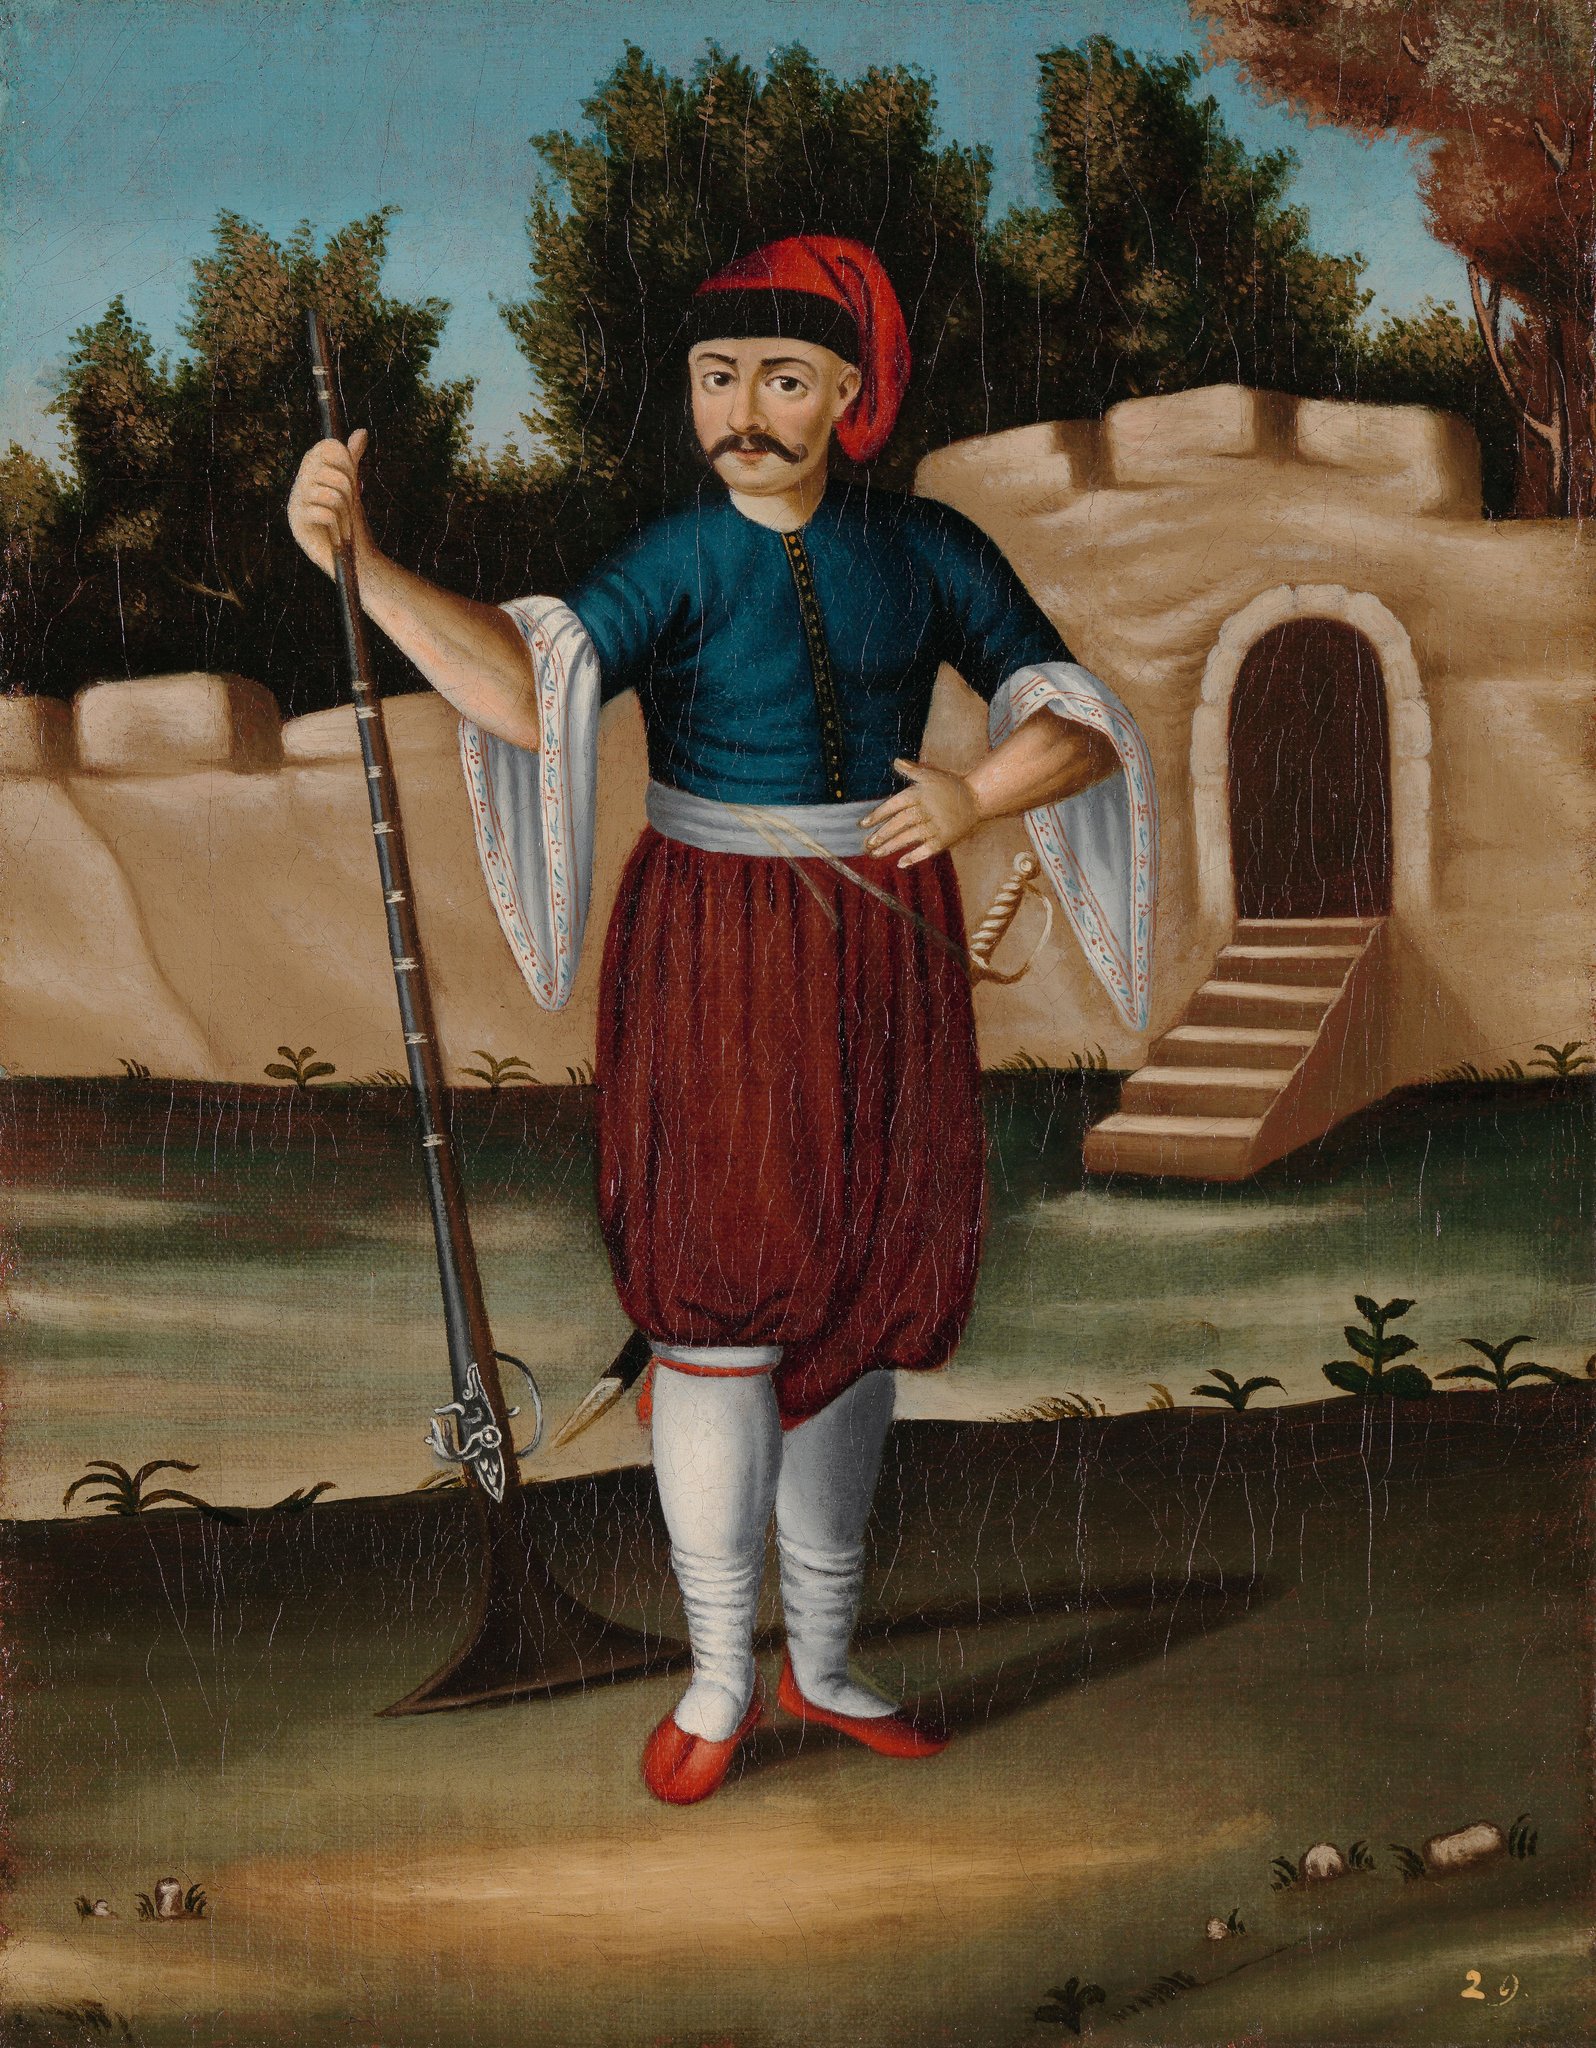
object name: painting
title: Man from the Albanian Coast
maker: jean baptiste vanmour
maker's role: painter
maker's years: 1671-1737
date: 1700-1737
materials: canvas, oil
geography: istanbul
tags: standing figure, folk costume, regional costume, the soldier; the soldier's life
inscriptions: number: ‘29’, inscription: ‘Arbanes / Een man van de kust Arbano’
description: Een man van de Albanese kust. Soldaat, staande, ten voeten uit, de rechterhand op de loop van zijn geweer.